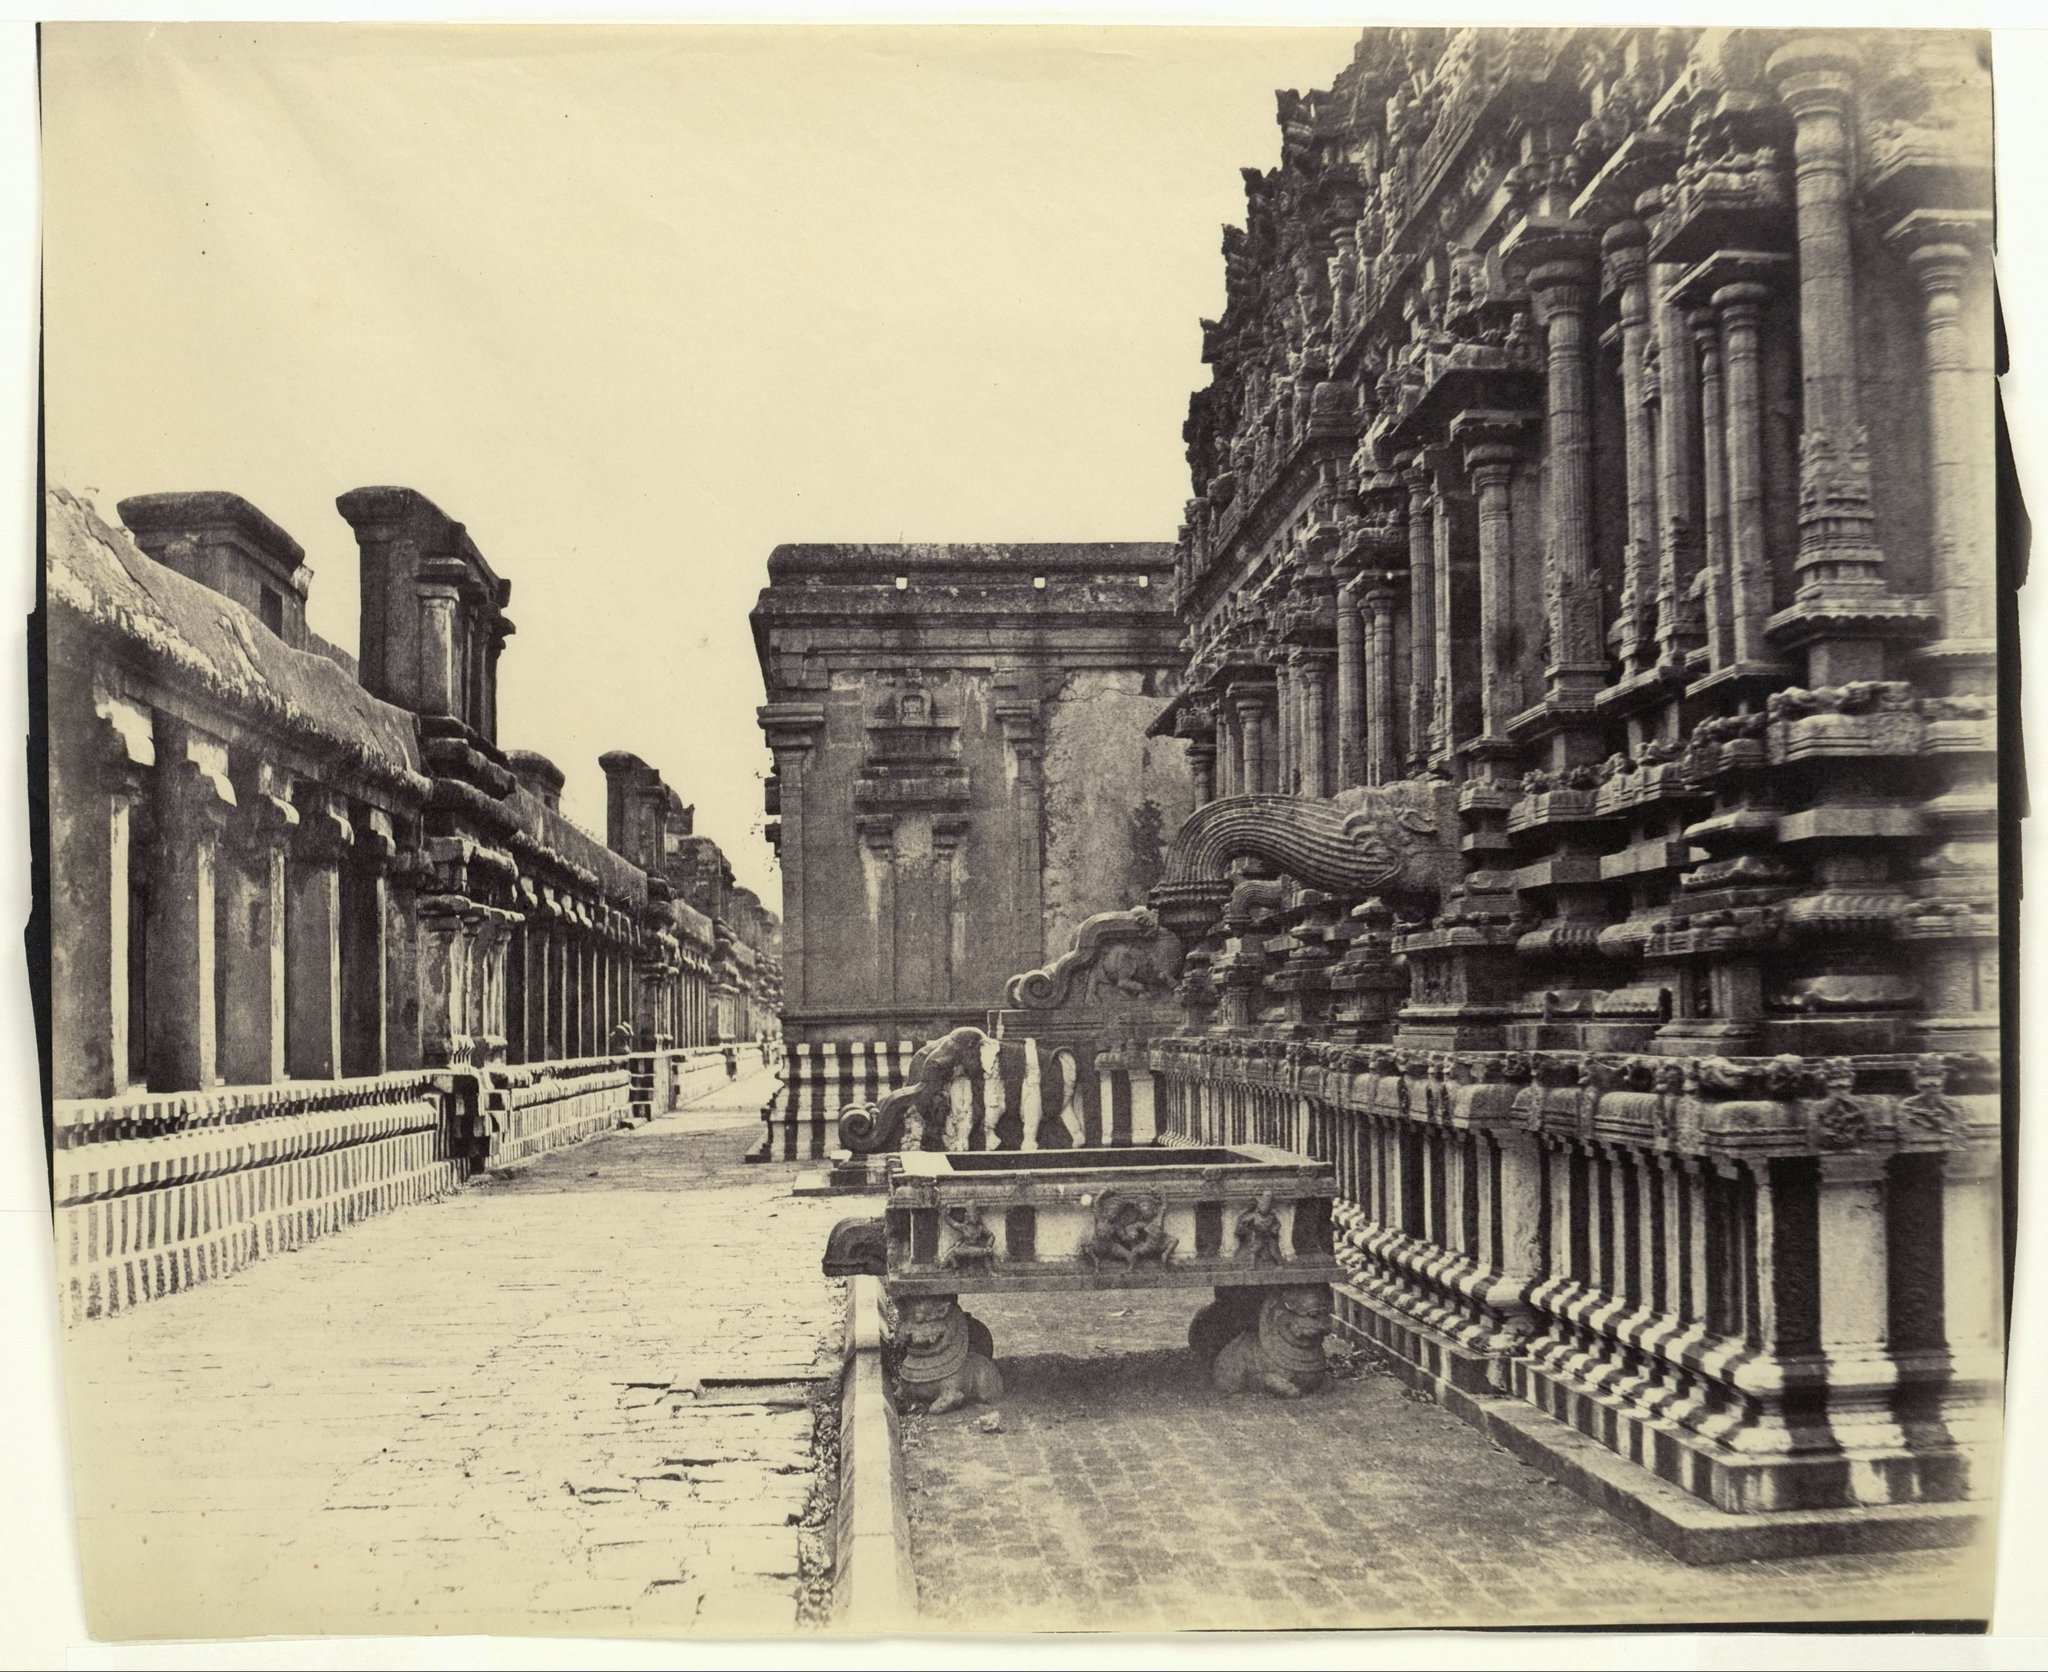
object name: photograph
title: A consecrated cistern and gargoyle at the Subrahmanya Temple in Thanjavur, Tamil Nadu, India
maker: linnaeus tripe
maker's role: fotograaf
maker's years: 1822-1902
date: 1858-1860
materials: photographic support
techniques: salted paper print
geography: india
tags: temple, shrine ~ hinduism, buddhism, jainism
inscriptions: number: ‘10’